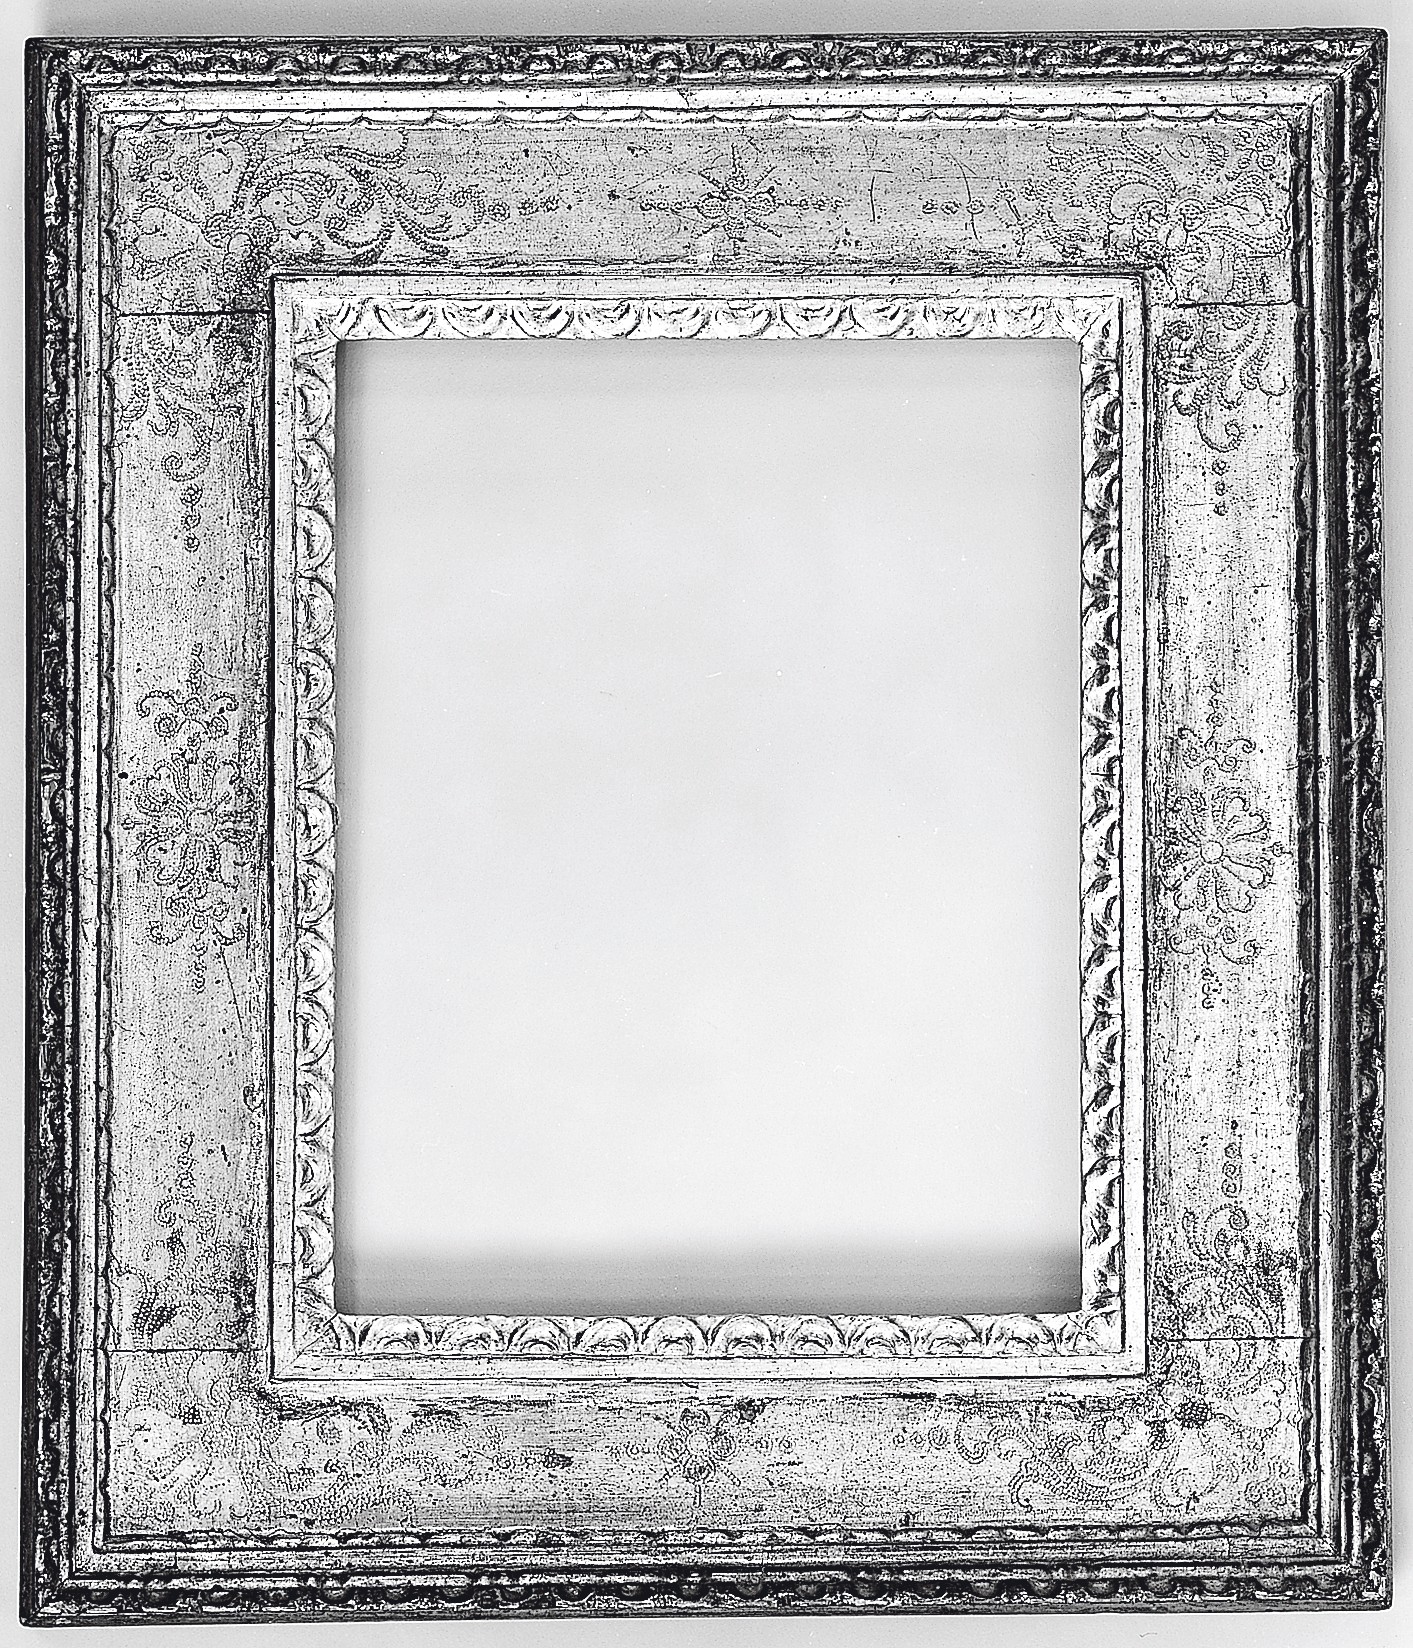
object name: frame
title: Cassetta frame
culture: italian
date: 1600-1610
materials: wood